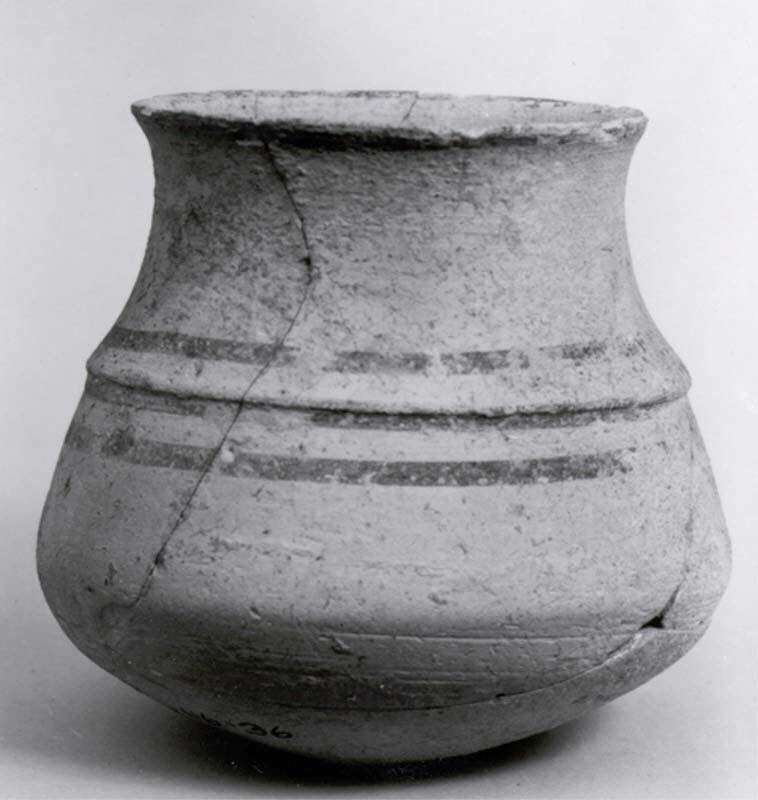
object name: jar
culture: iranian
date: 2000-1600 BCE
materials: ceramic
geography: iran, luristan